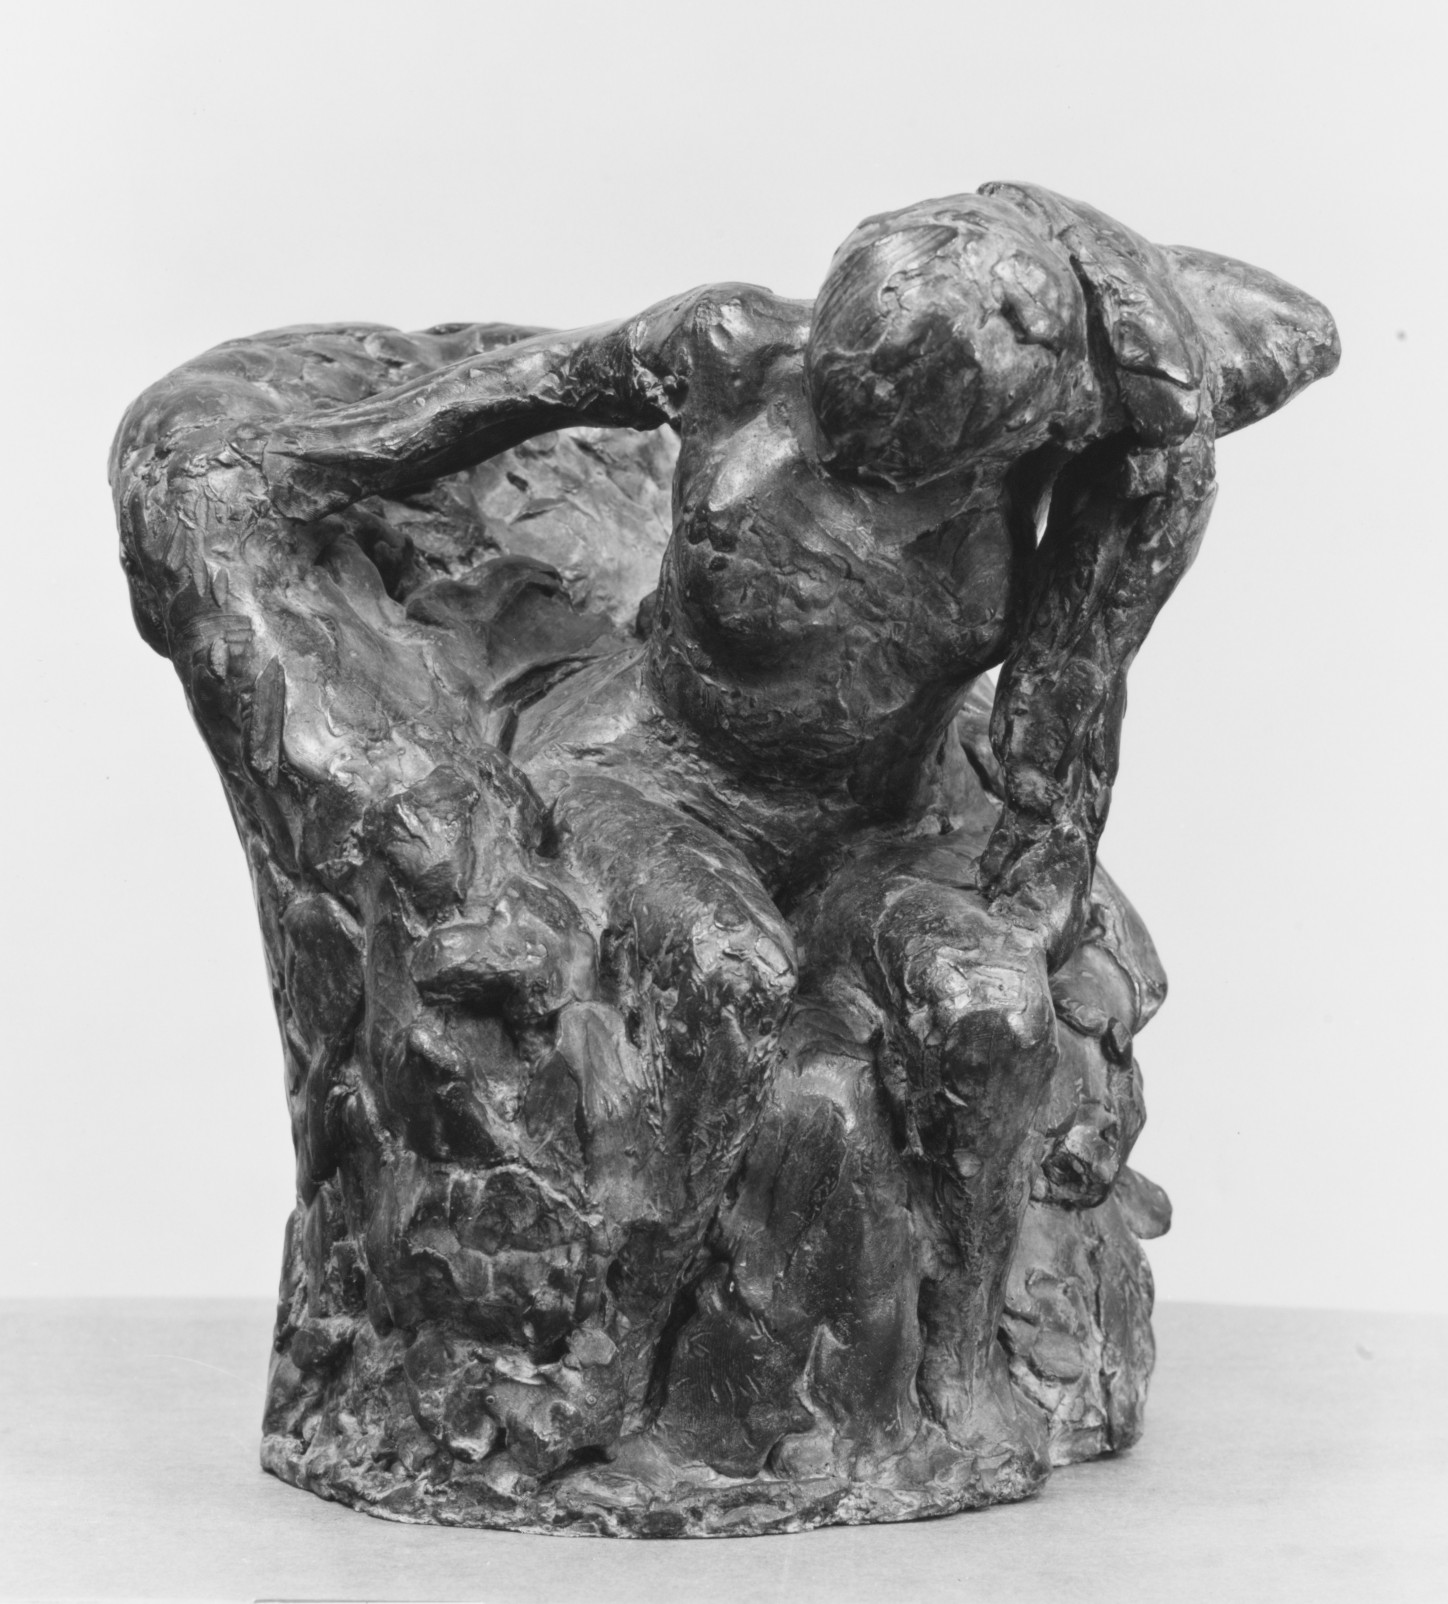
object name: statuette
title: Woman Seated in an Armchair Wiping Her Neck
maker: edgar degas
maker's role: artist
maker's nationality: french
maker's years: 1834-1917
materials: bronze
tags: women